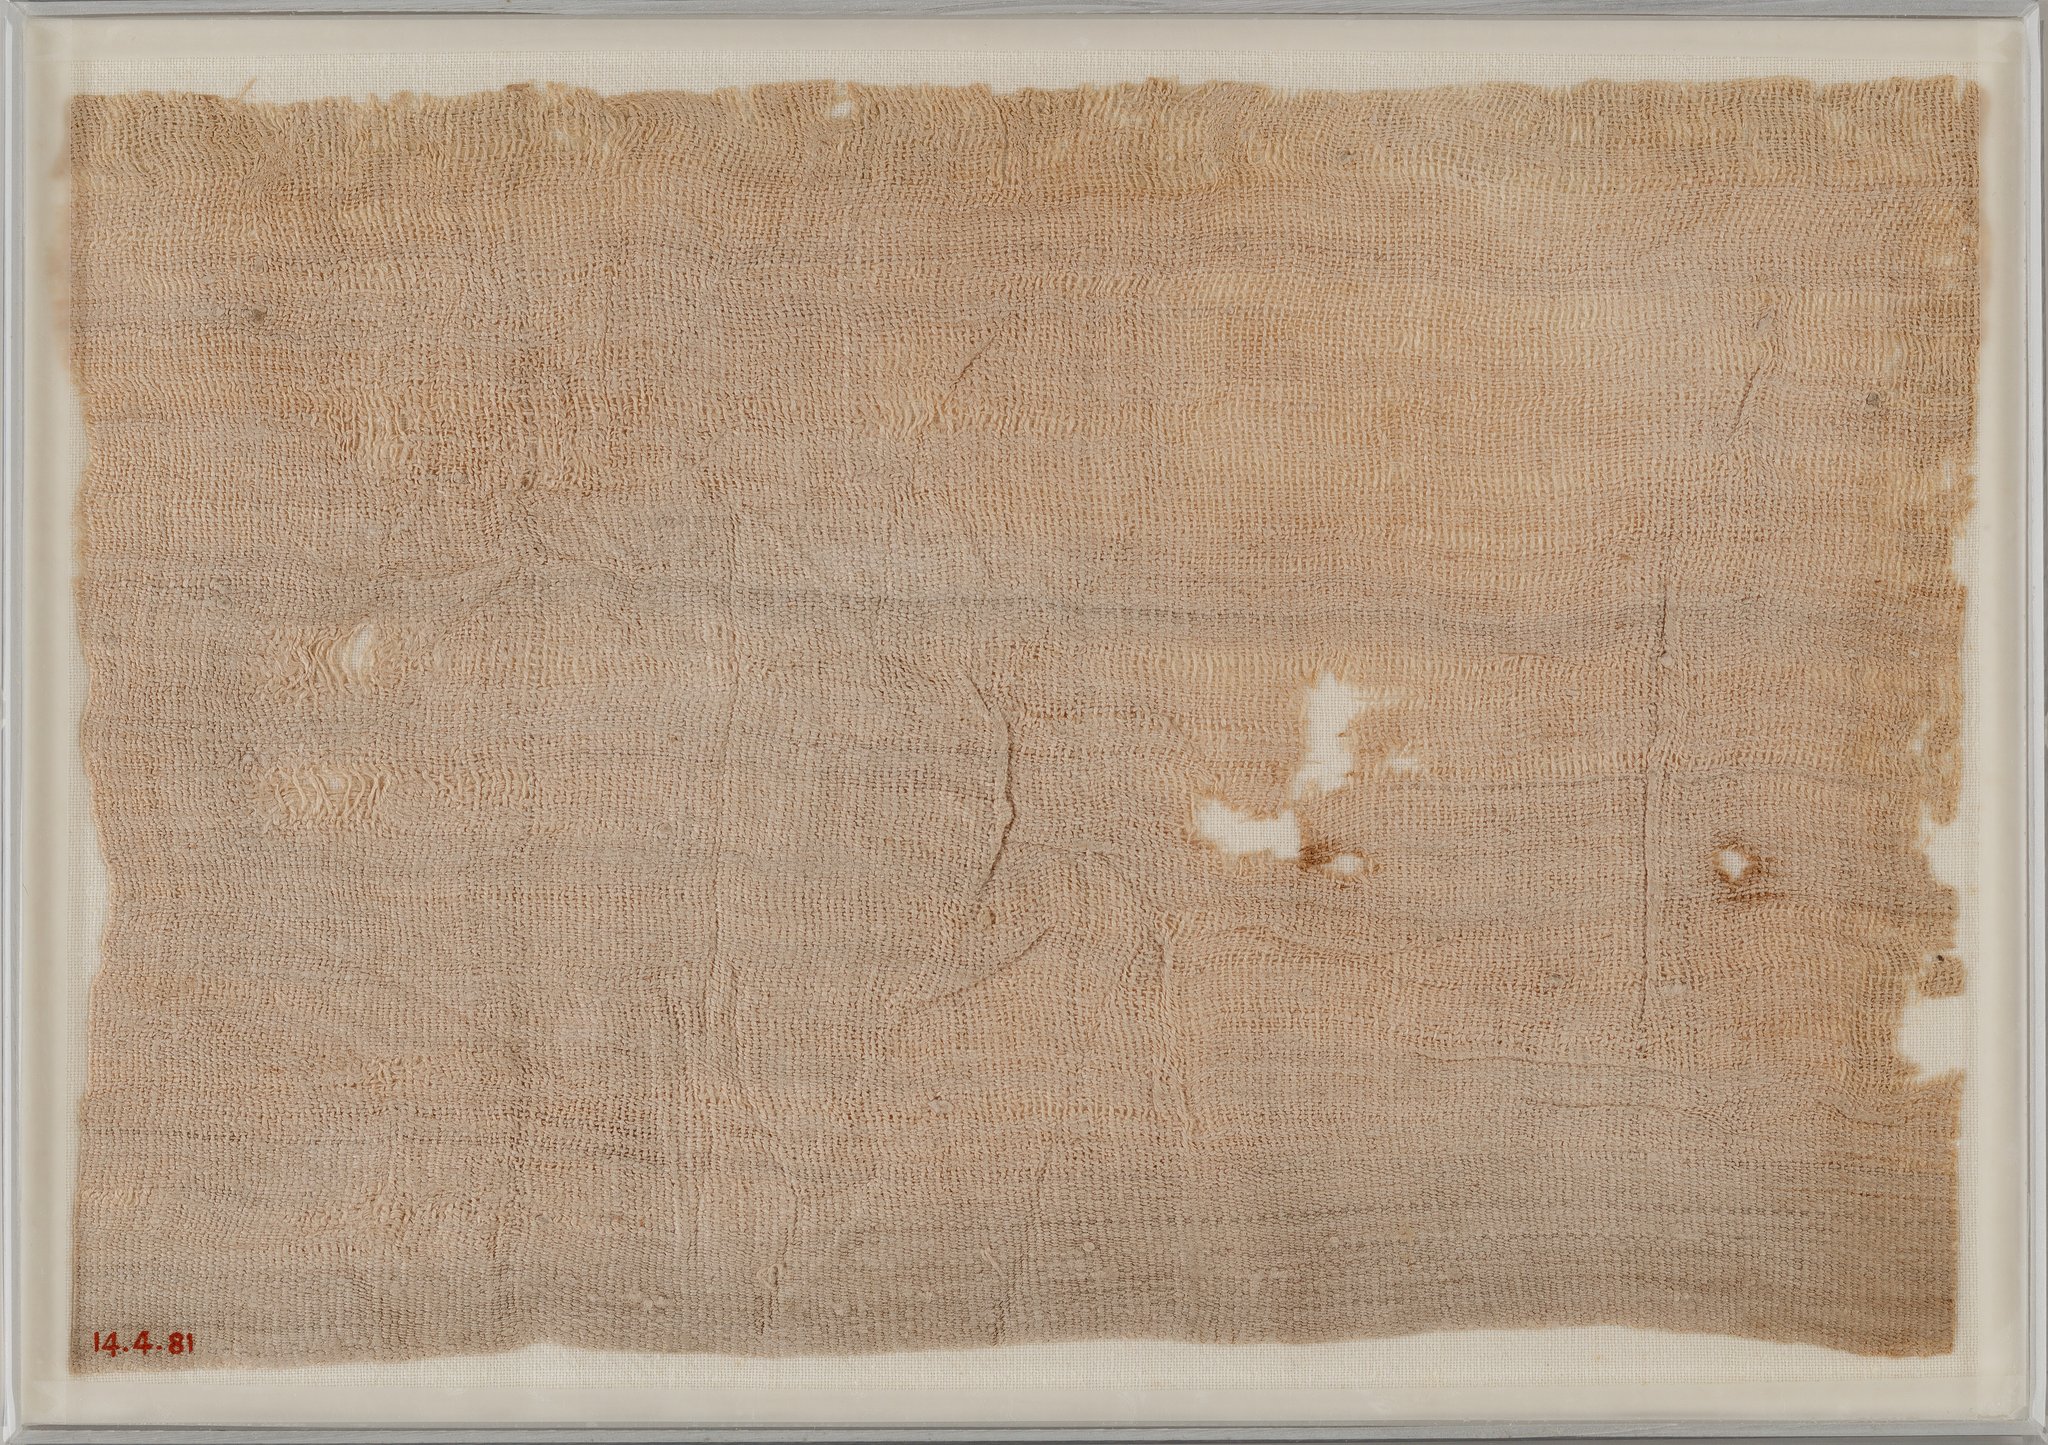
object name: linen fragment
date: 2880-2465 BCE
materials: linen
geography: egypt